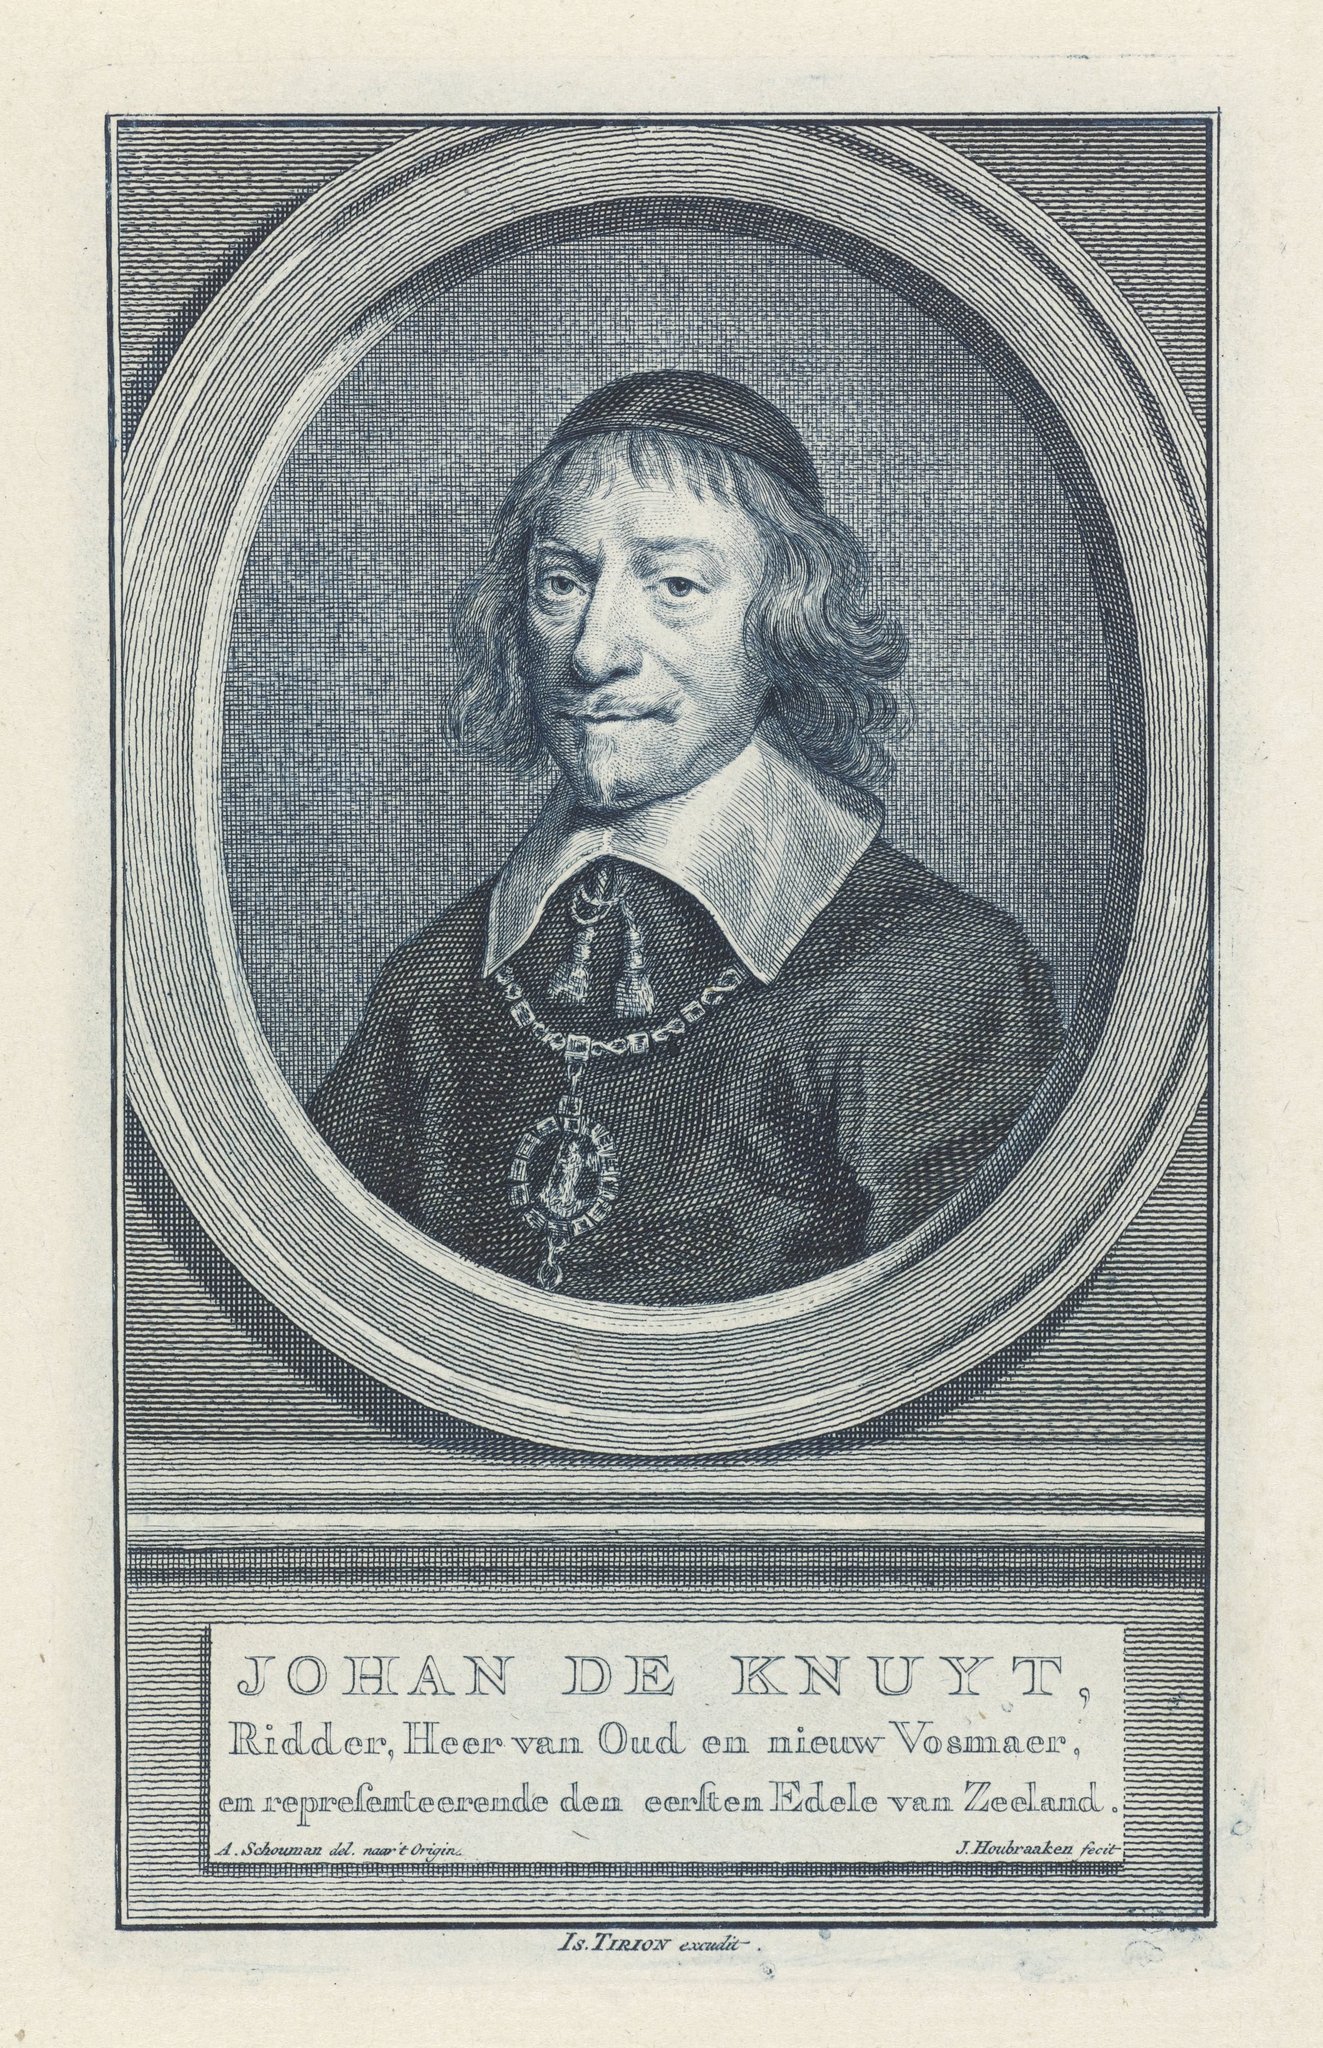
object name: print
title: Portret van Johan de Knuyt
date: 1749-1759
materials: paper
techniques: engraving, etching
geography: amsterdam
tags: johan de knuyt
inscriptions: collector's mark: Lugt 2228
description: Druk in blauw. Prent ook gebruikt in: Jan Wagenaar, Vaderlandsche historie, vervattende de geschiedenissen der nu Vereenigde Nederlanden, inzonderheid die van Holland (...), 21 delen. Amsterdam, Isaak Tirion, 1749-59. Druk in blauw. Prent volgens Ver Huell ook gebruikt in: Portraiten van eenige der vermaardste staatsmannen en zeehelden, als toevoeging op: Willem Tiberius Hattinga, Atlas van Zeeland. Amsterdam: Isaak Tirion, 1760.